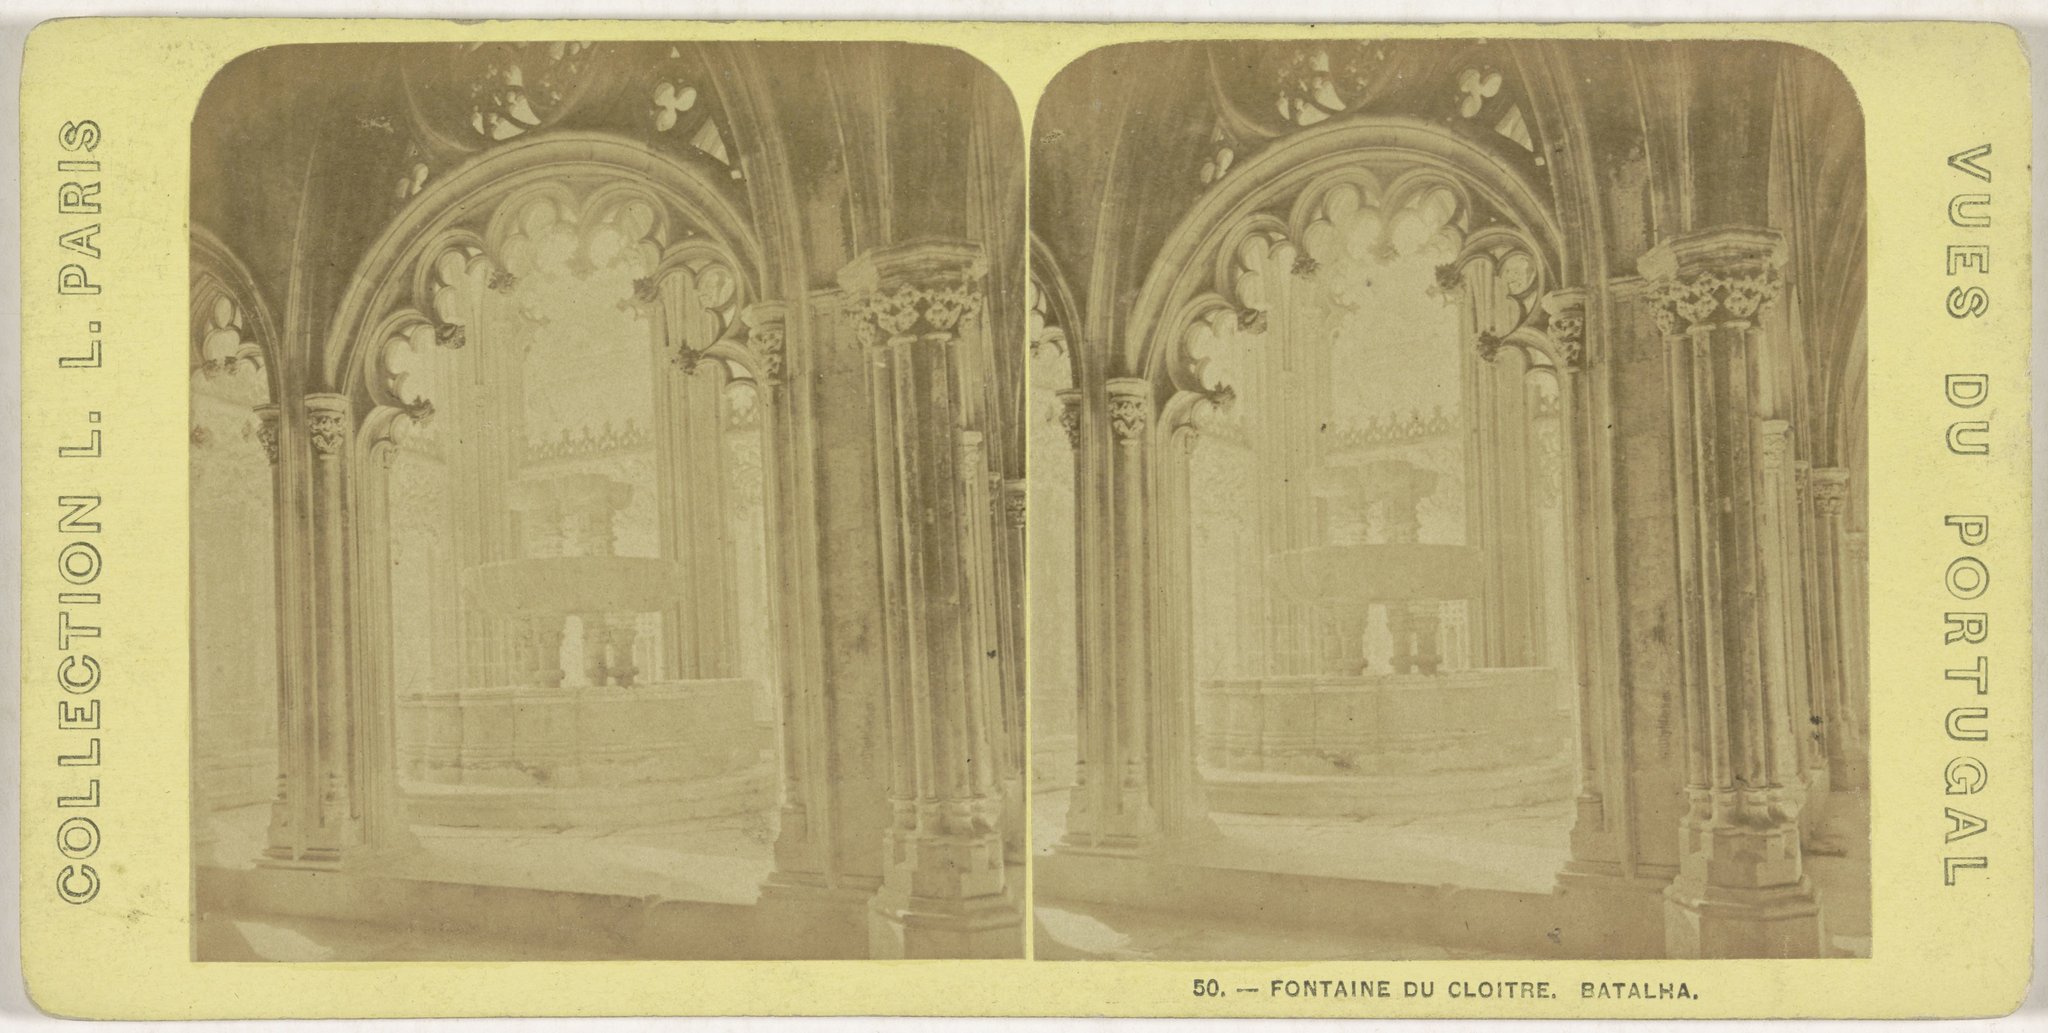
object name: stereograph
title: Vues du Portugal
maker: Anonymous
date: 1868-1890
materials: cardboard, paper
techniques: albumen print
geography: paris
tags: abbey, monastery, convent ~ roman catholic church, ornamental fountain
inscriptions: number: ‘50’